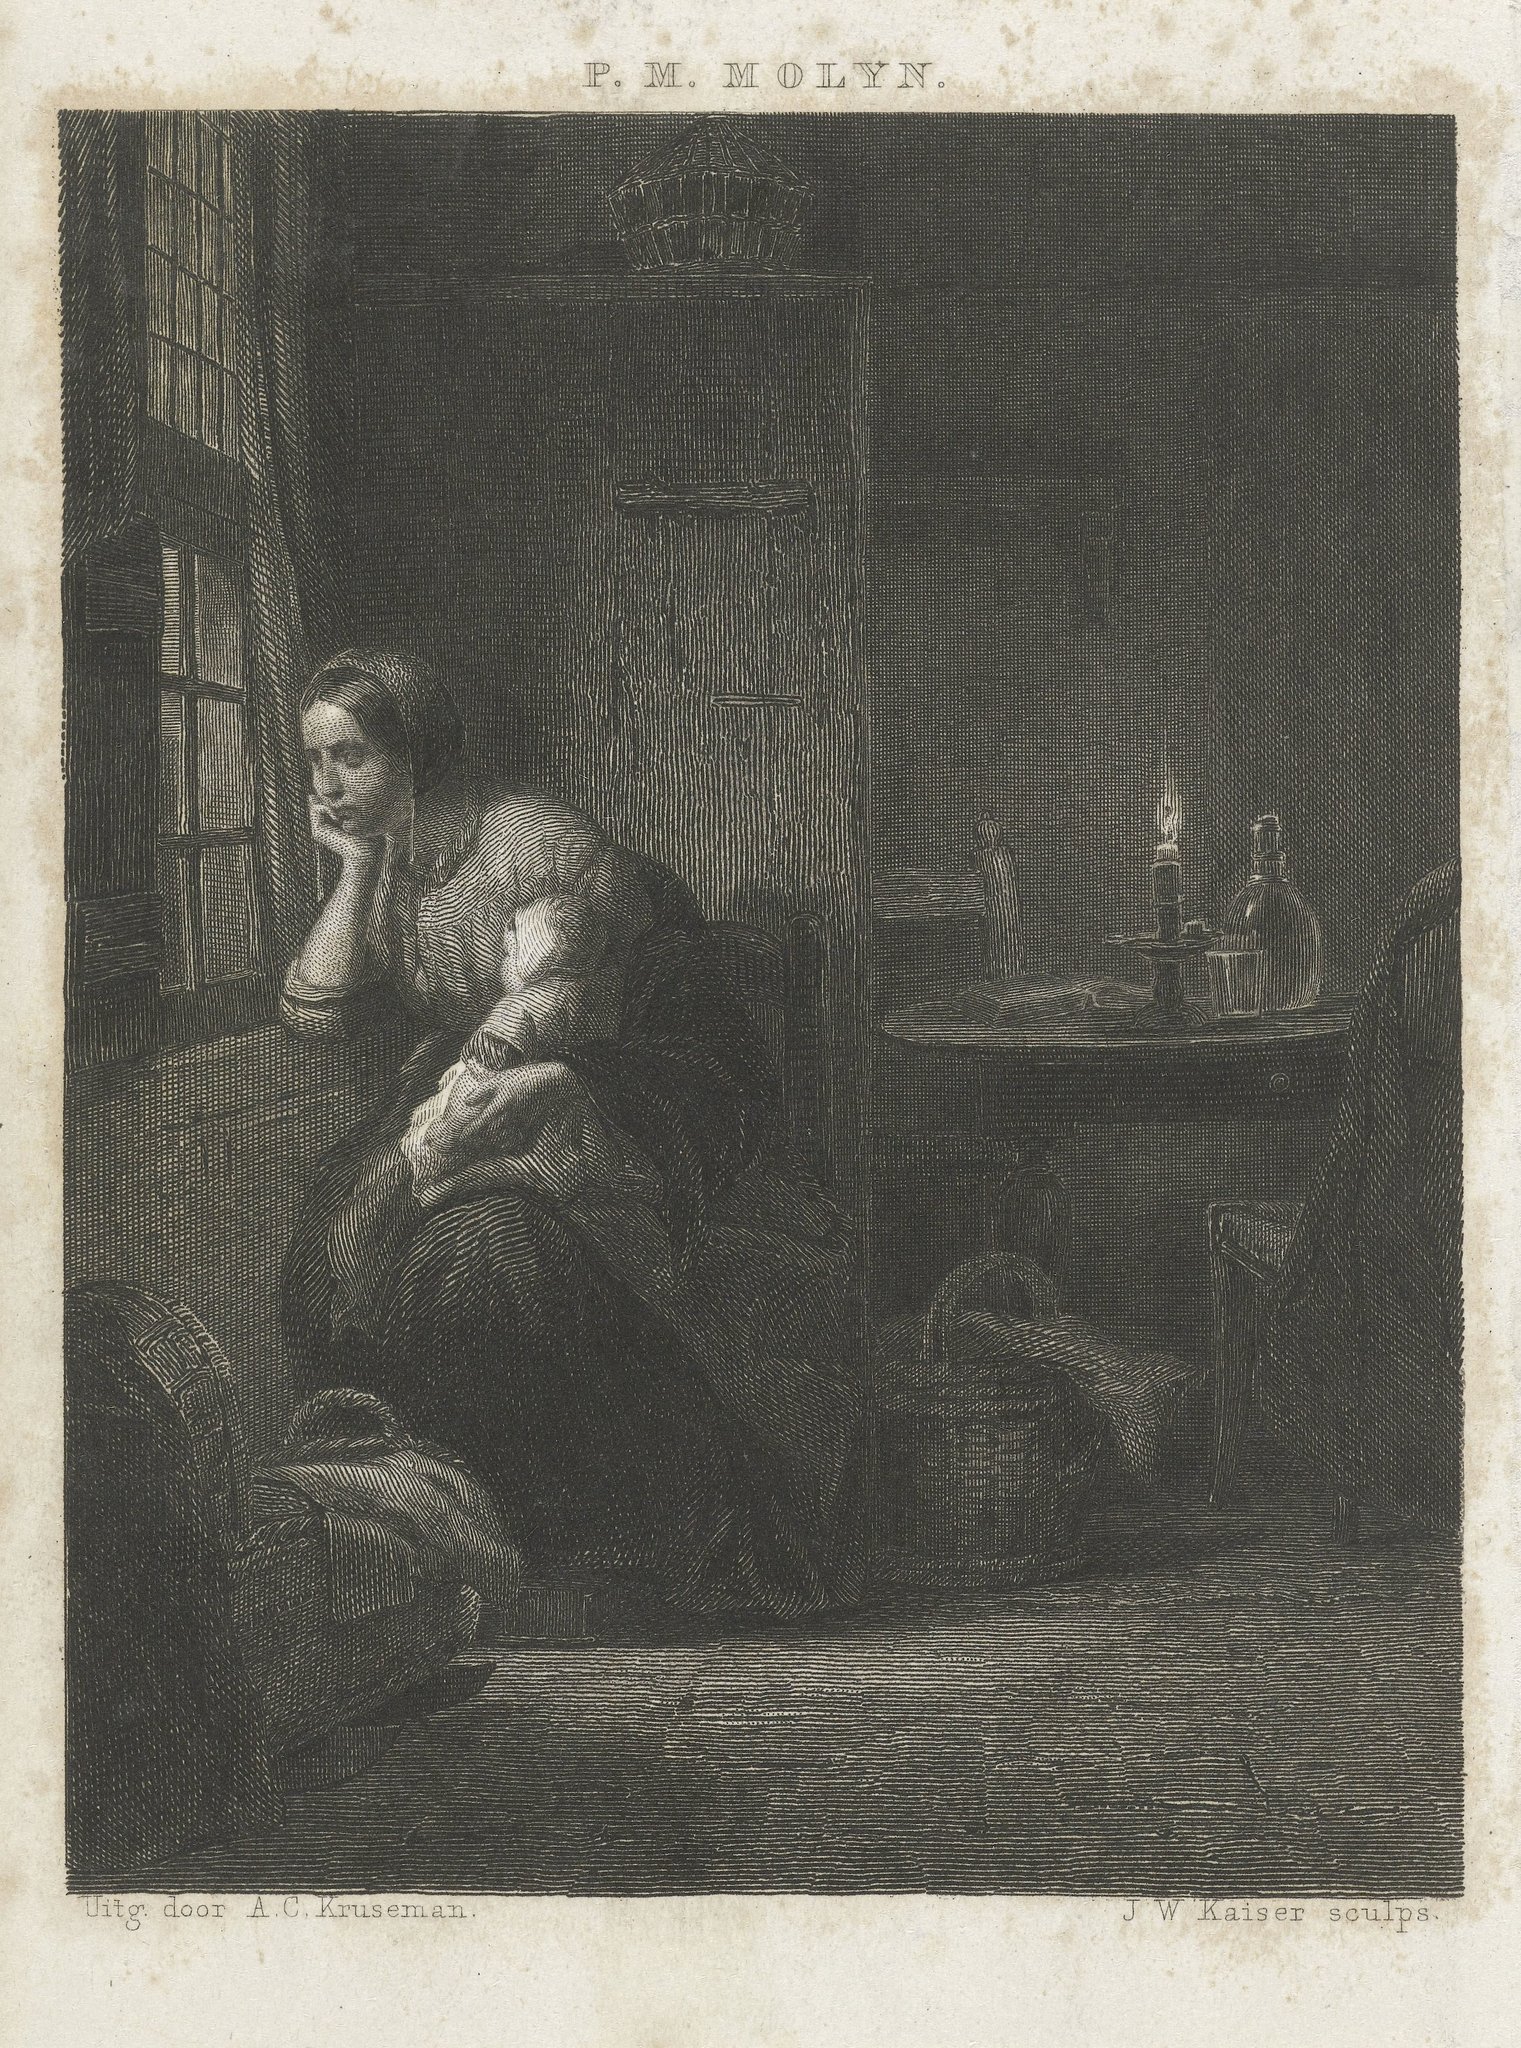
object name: print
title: Vrouw met kind bij een venster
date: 1852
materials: paper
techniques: etching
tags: cradle, crib, mother and child(ren), woman and child(ren) (family group)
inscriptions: collector's mark: Lugt 2228, inscription: ‘De wachtende, uit Aurora 1852’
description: In een schemerig vertrek zit een vrouw te wachten bij het venster. Ze heeft een kind op schoot en tuurt naar buiten. Voor haar staat een wieg en op tafel brandt een kaars.